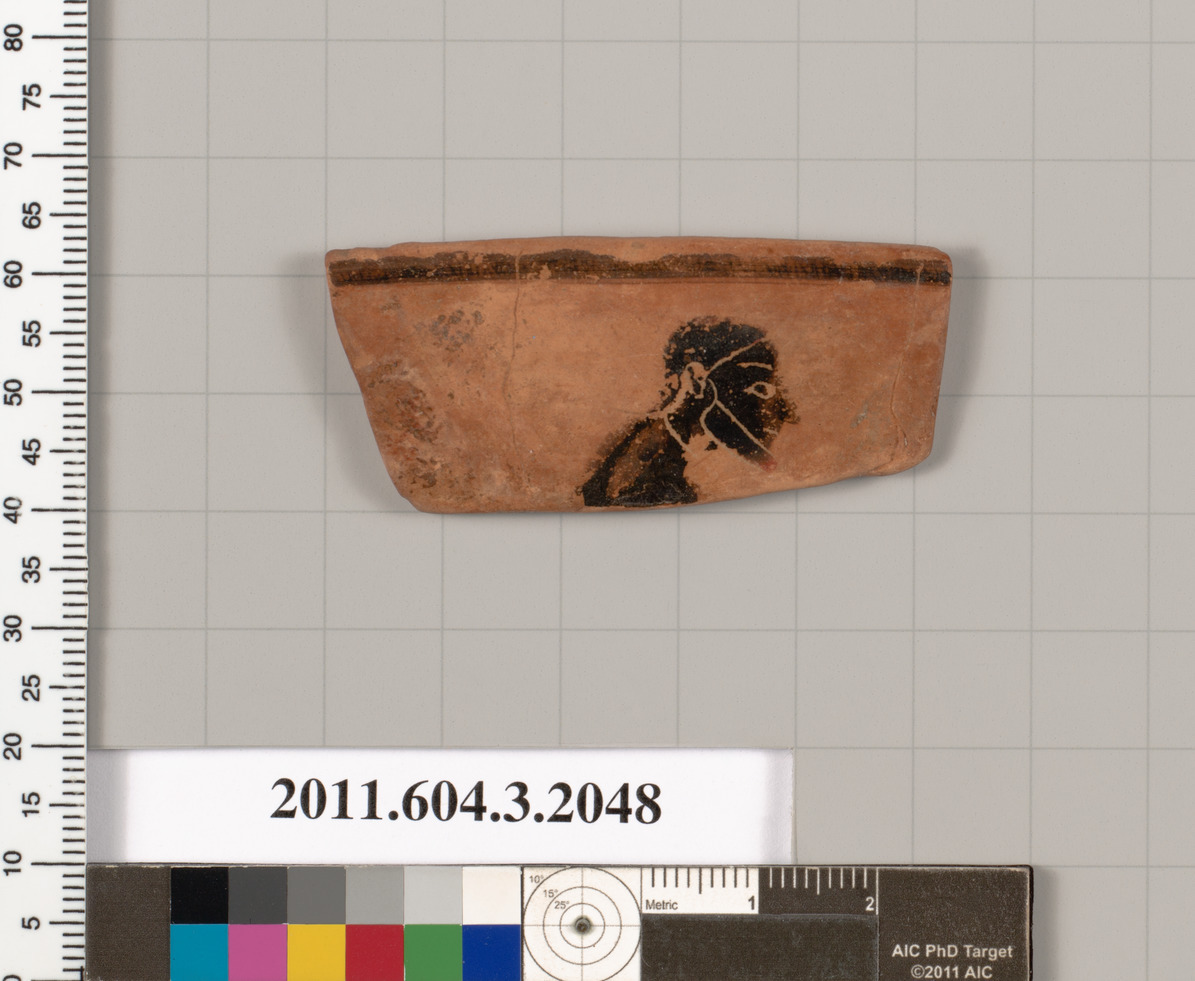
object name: kylix fragment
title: Terracotta rim fragment of a kylix (drinking cup)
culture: greek, attic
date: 534-501 BCE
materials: terracotta